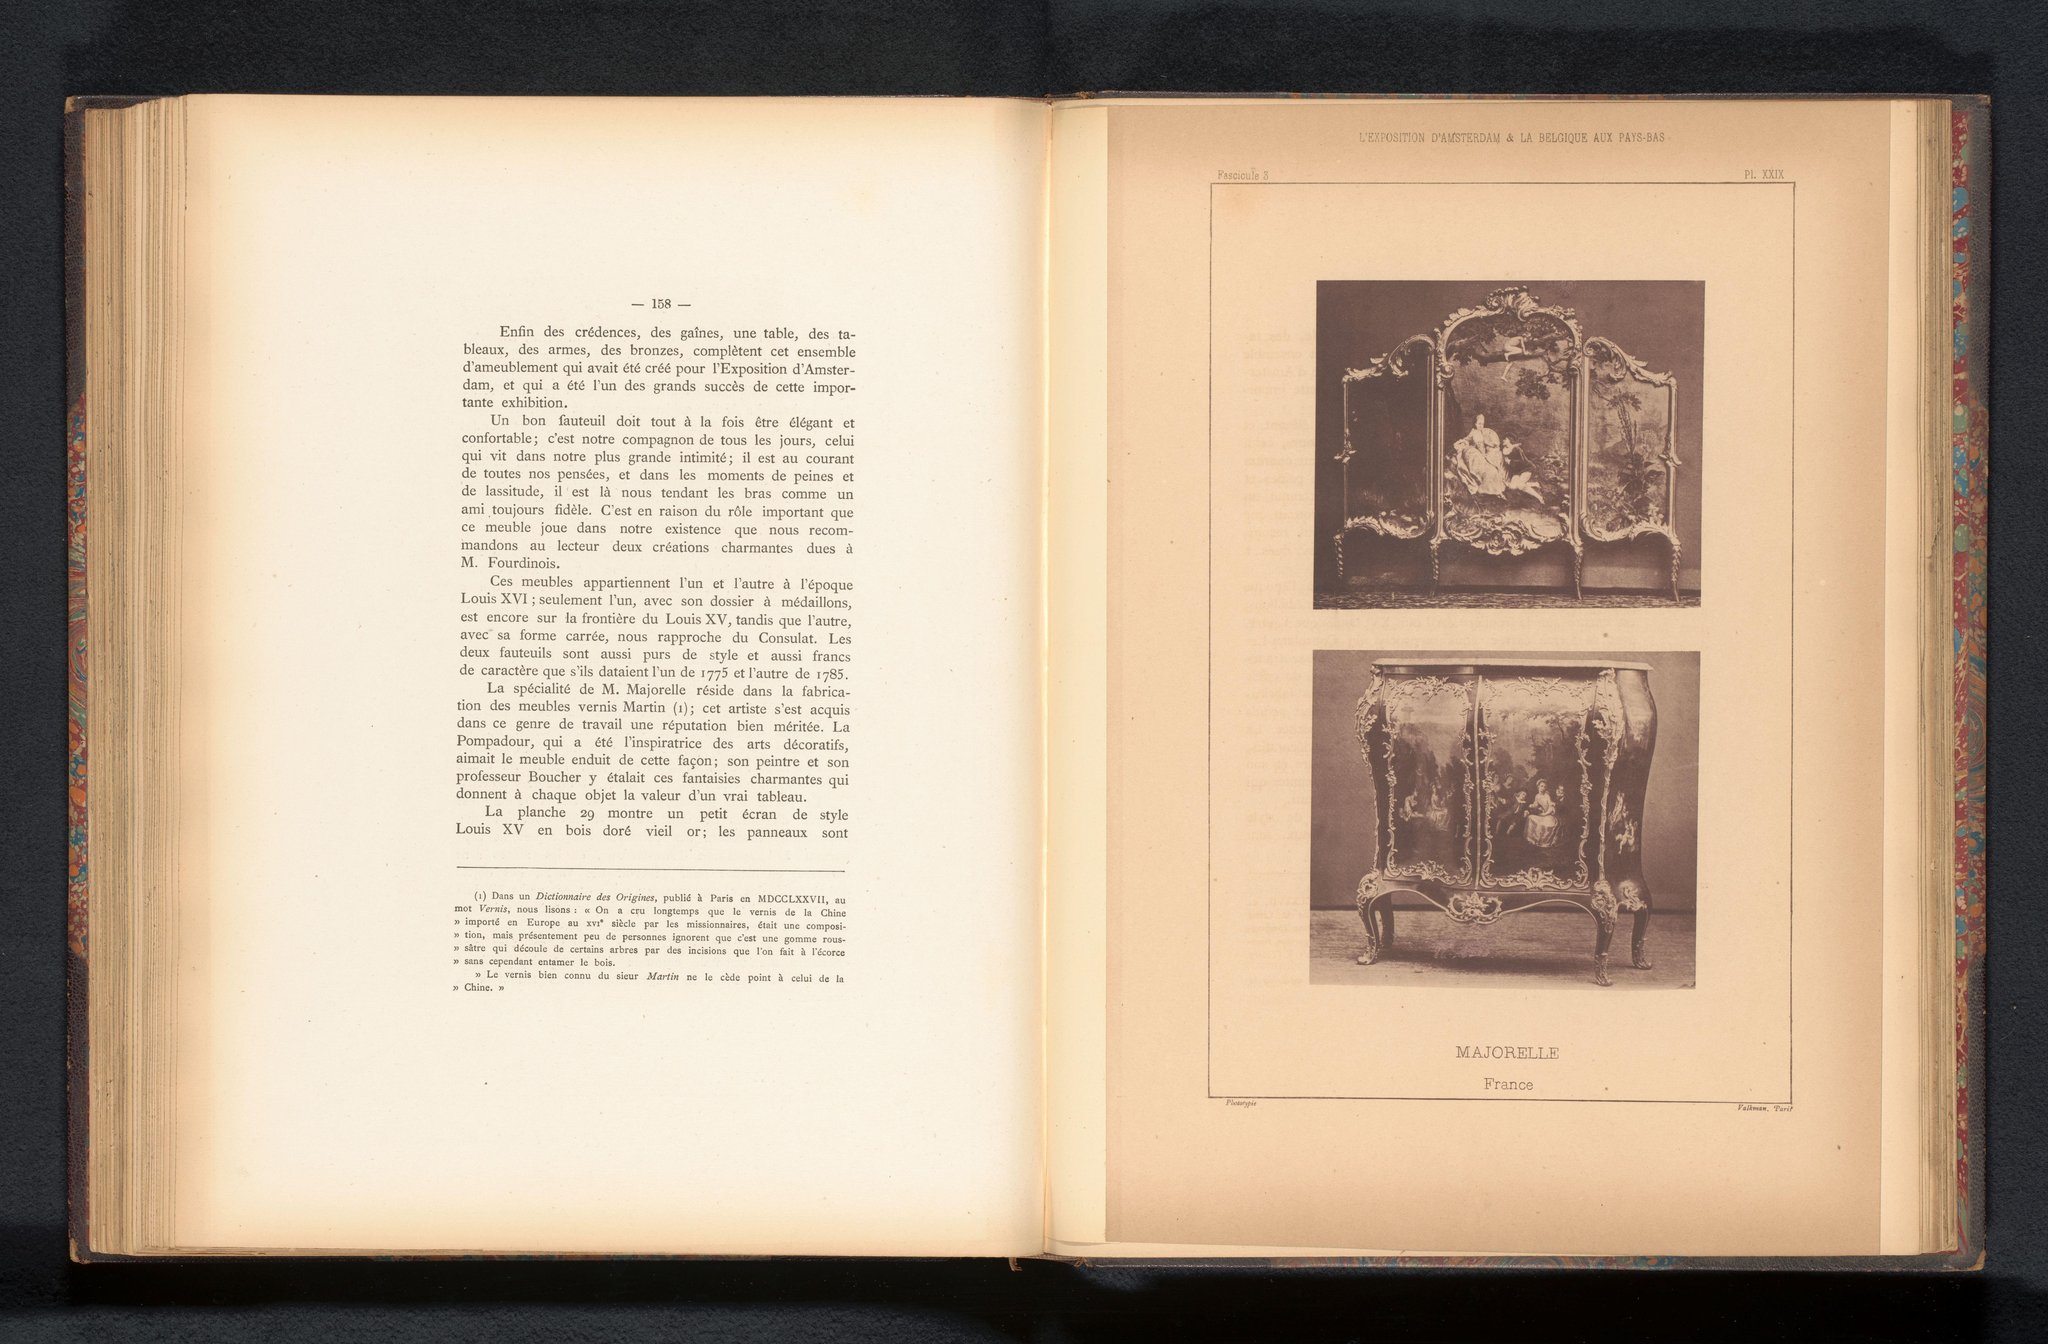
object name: photomechanical print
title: Twee opnames van meubels vervaardigd door Louis Majorelle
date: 1878-1883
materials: paper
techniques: photograph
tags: decorative furniture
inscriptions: inscription: ‘Majorelle/ France’, inscription: ‘Fascicule 3/ PL. XXIX’